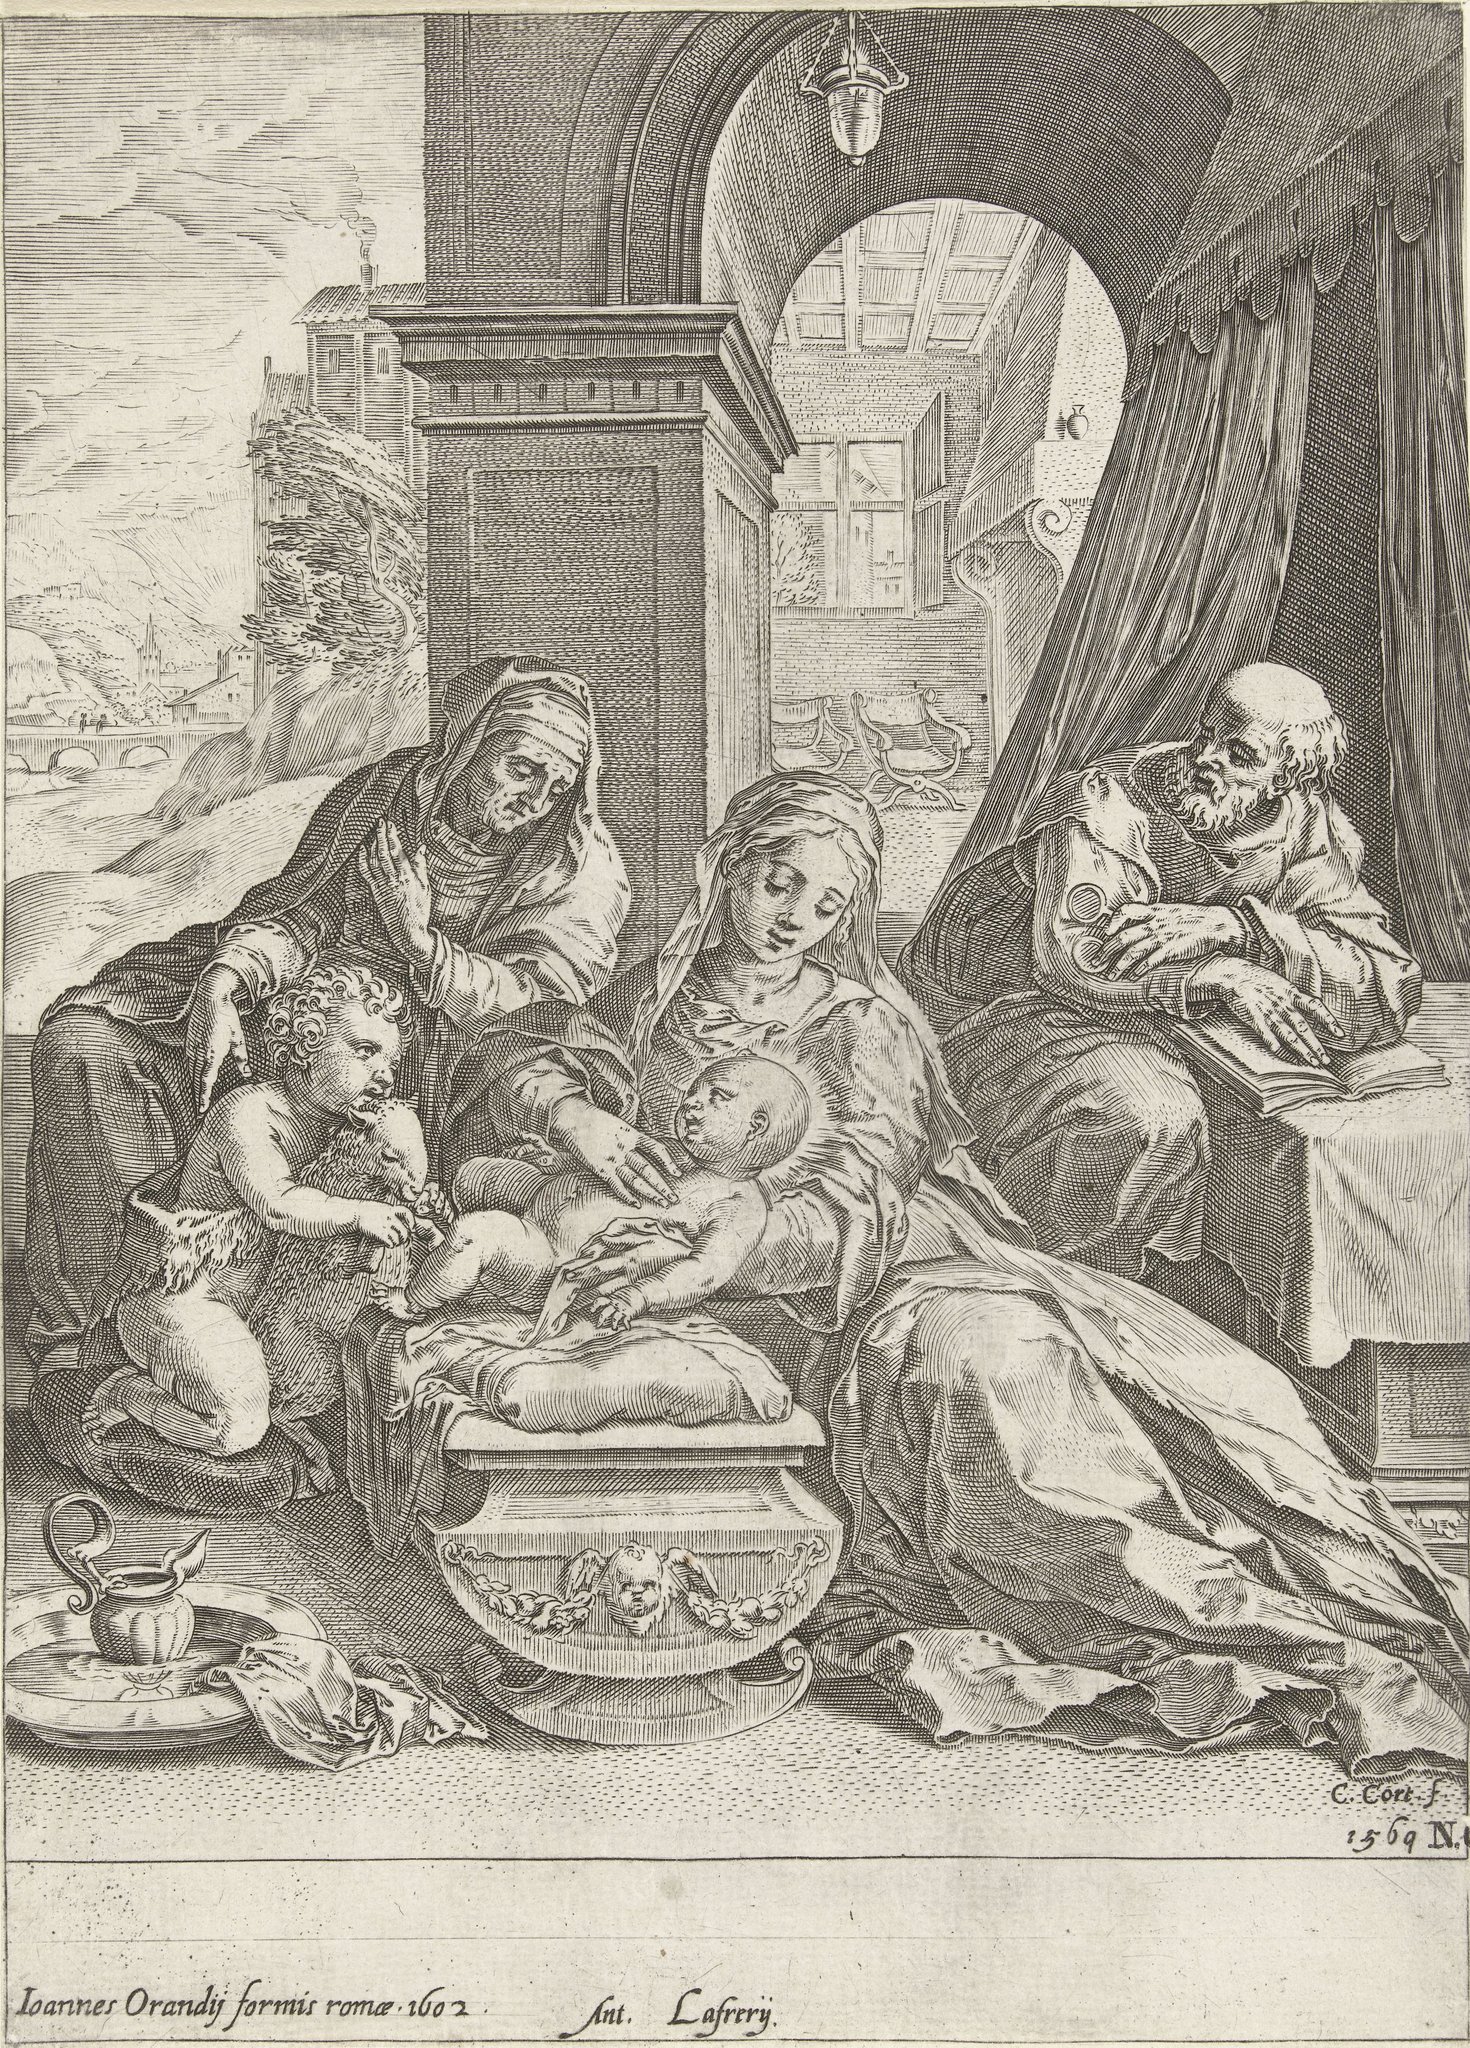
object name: print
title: Heilige Familie met Anna en Johannes de Doper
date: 1602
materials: paper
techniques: engraving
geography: rome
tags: holy family with others, e.g.: anna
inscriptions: signature: ‘C. Cort f.’, collector's mark: Lugt 1968, address: ‘Ioannes Orlandij formis romae.’, address: ‘Ant. Lafrerij’, collector's mark: Lugt 2228, date: ‘1569’, date: ‘1602’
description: Voor een arcade zitten Maria, Anna en Johannes de Doper als kind met het lam. Maria houdt het Kind vast dat op een wieg ligt. Rechts Jozef met een open boek op tafel, een bril in zijn hand. Linksachter uitzicht op een heuvelachtig landschap.